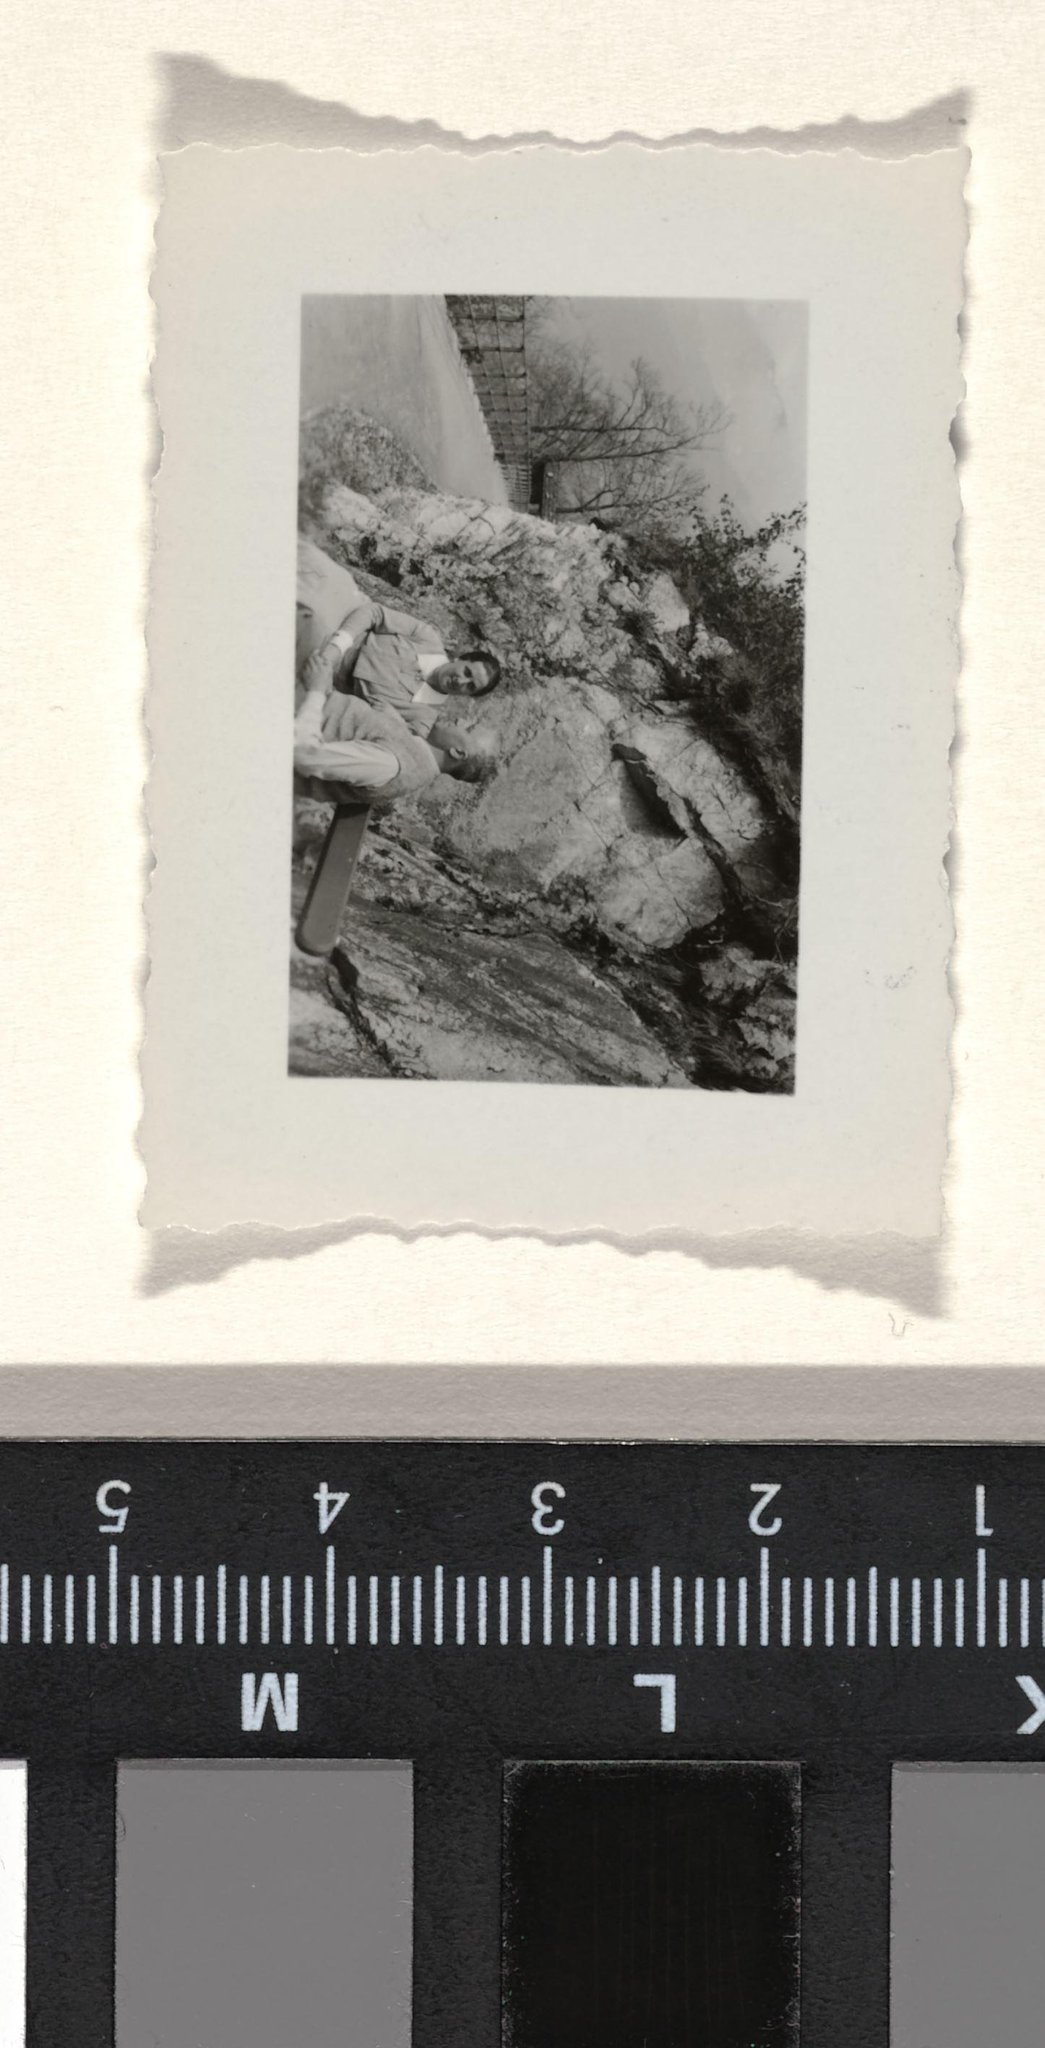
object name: photograph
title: Else Wachenheimer-Moos en haar echtgenoot Eugen Wachenheimer gezeten op een bankje voor een rotspartij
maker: Anonymous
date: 1904-1936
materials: photographic support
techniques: gelatin silver print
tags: eugen wachenheimer, else wachenheimer-moos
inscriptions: date: ‘April 36. Meran.’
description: Else Wachenheimer-Moos (links) en haar echtgenoot Eugen Wachenheimer (rechts) gezeten op een bankje voor een rotspartij.